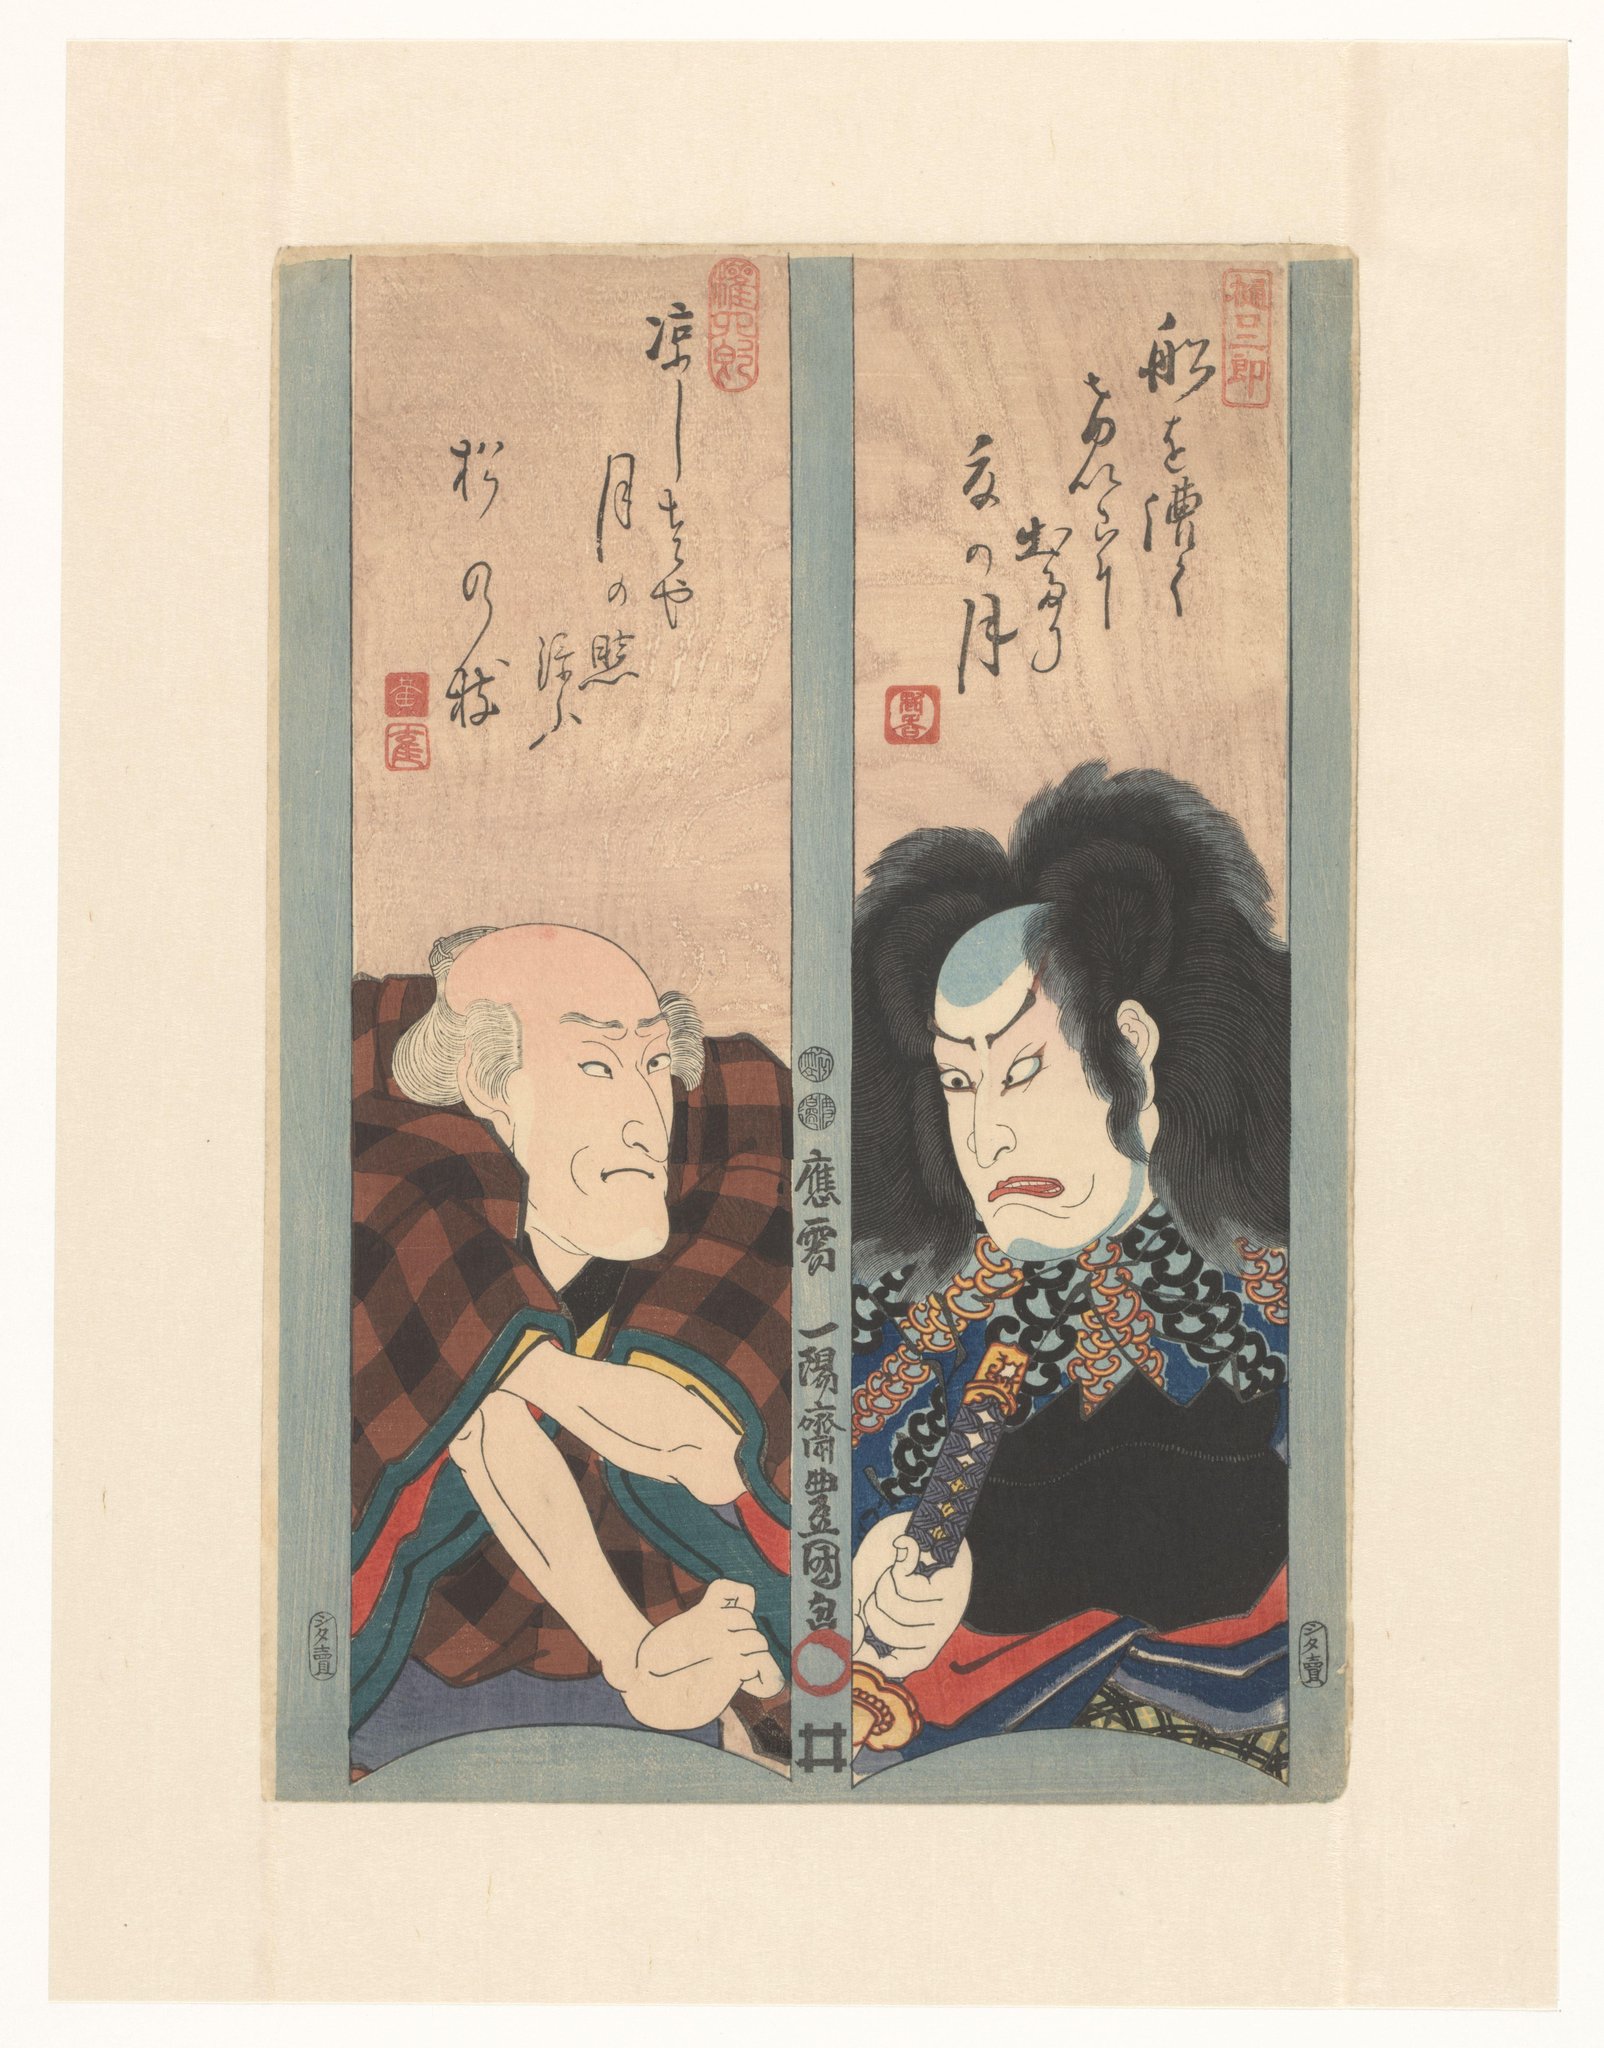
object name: print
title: Twee acteurs op versstroken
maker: utagawa kunisada (i)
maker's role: print maker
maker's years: 1786-1865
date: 1850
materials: paper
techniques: woodcut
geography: japan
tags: group of actors, troupe; actors on the stage, adult man, old man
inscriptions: collector's mark: ‘afbeelding van een origami kraanvogel’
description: Twee acteurs, elk afgebeeld binnen een kader en onder een gedicht, waardoor het lijkt alsof het om twee gedicht stroken gaat, kijken elkaar aan. Rechts, kabuki acteur Nakamura Utaemon IV in de rol van de schipper Matsuemon. Links, Seki Sanjûrô III als schipper Gonshirô.